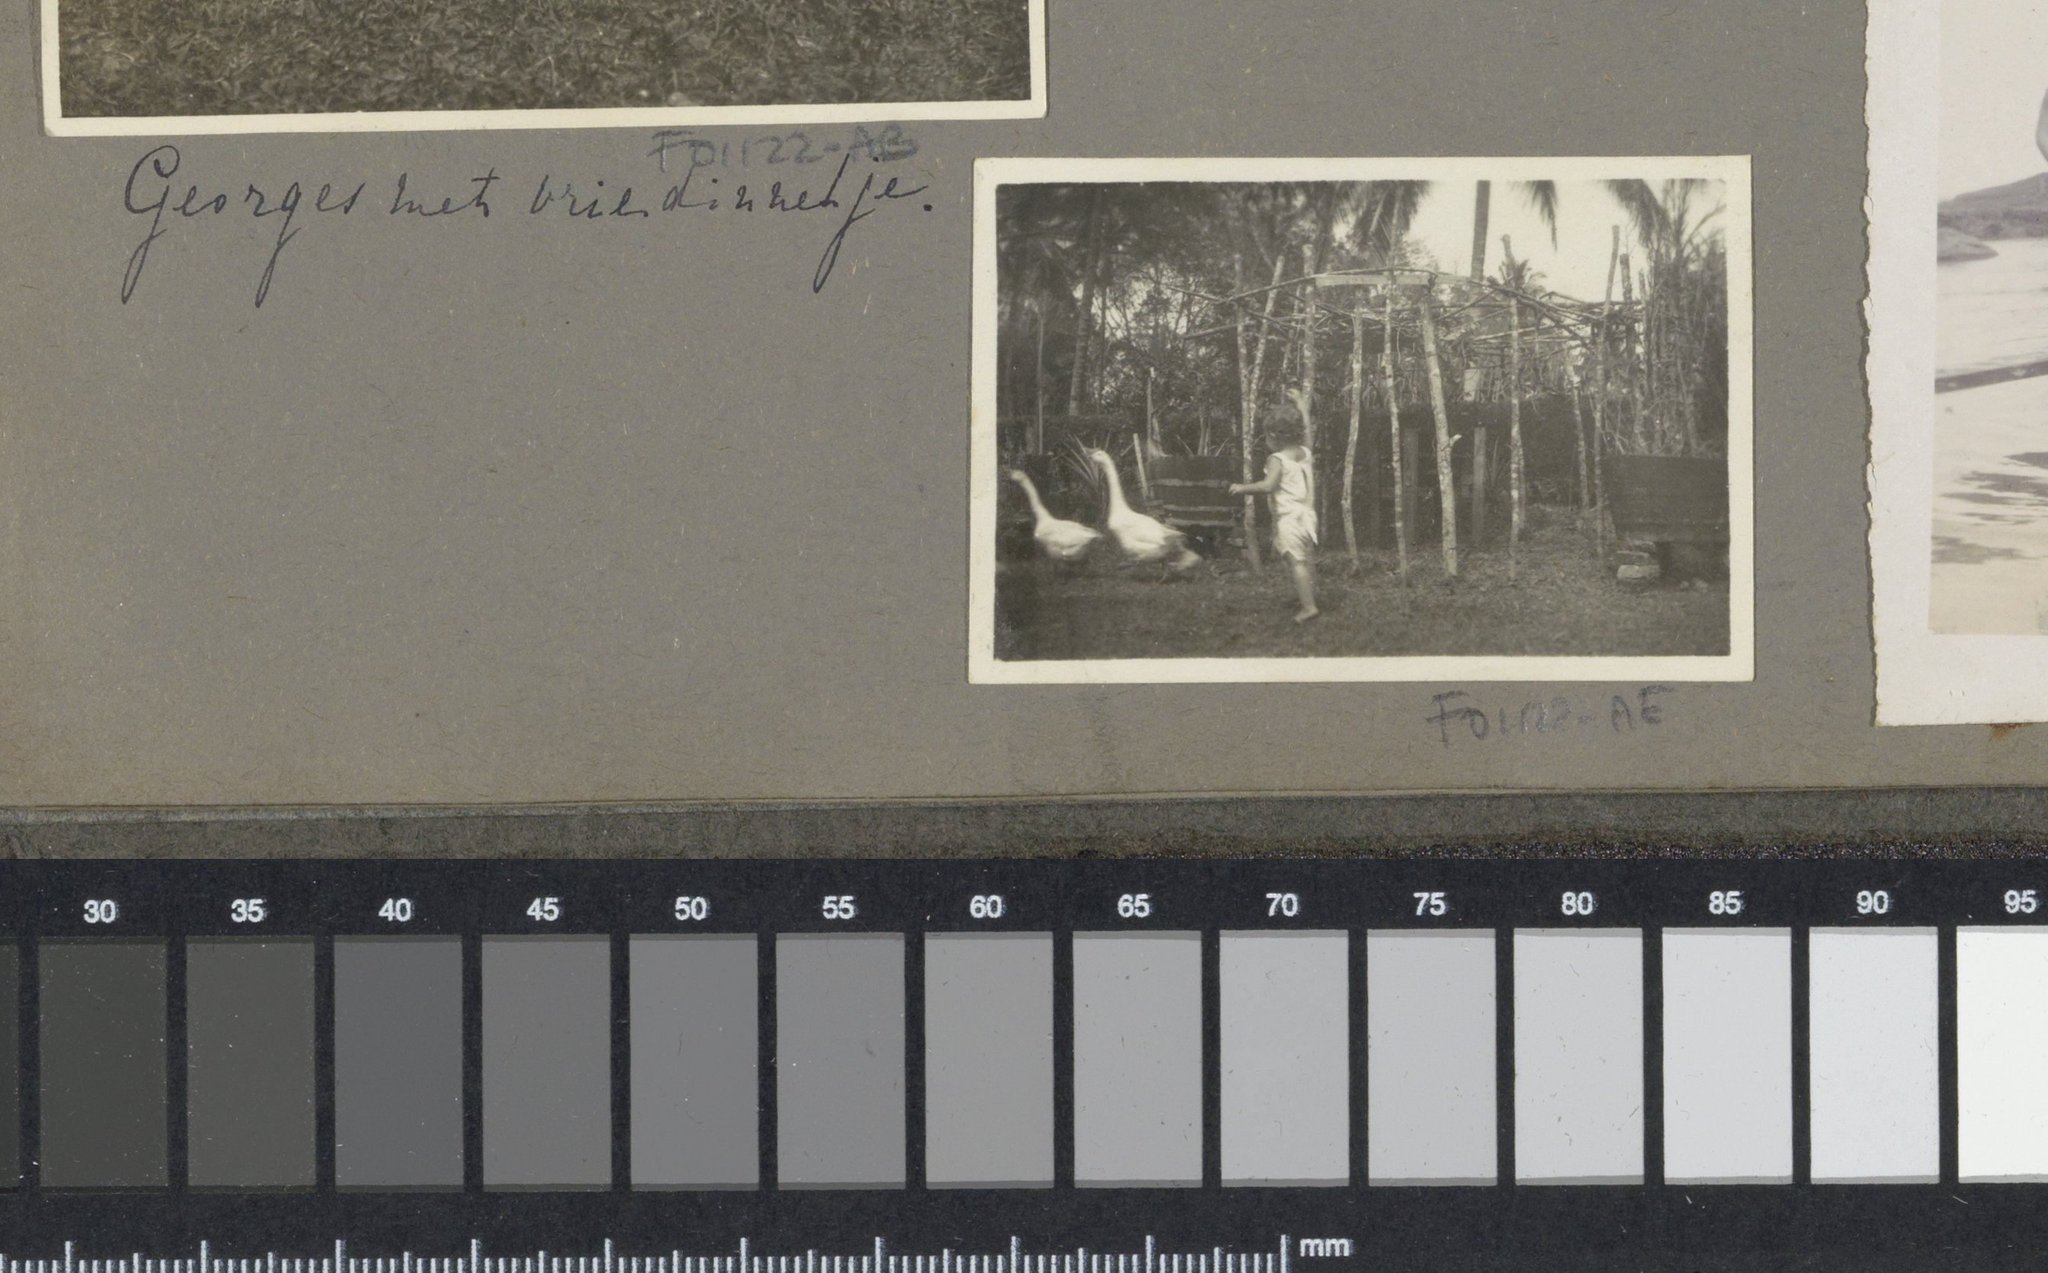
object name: photograph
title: Kind met ganzen in een tuin op Sumatra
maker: Anonymous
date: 1914-1926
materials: photographic support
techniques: gelatin silver print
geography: sumatra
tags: water-birds: goose, infant, baby, sumatra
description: Onderdeel van fotoalbum met opnames van de familie Bergsma in Tandjong Poera en Rantan Pandjang (Sumatra).